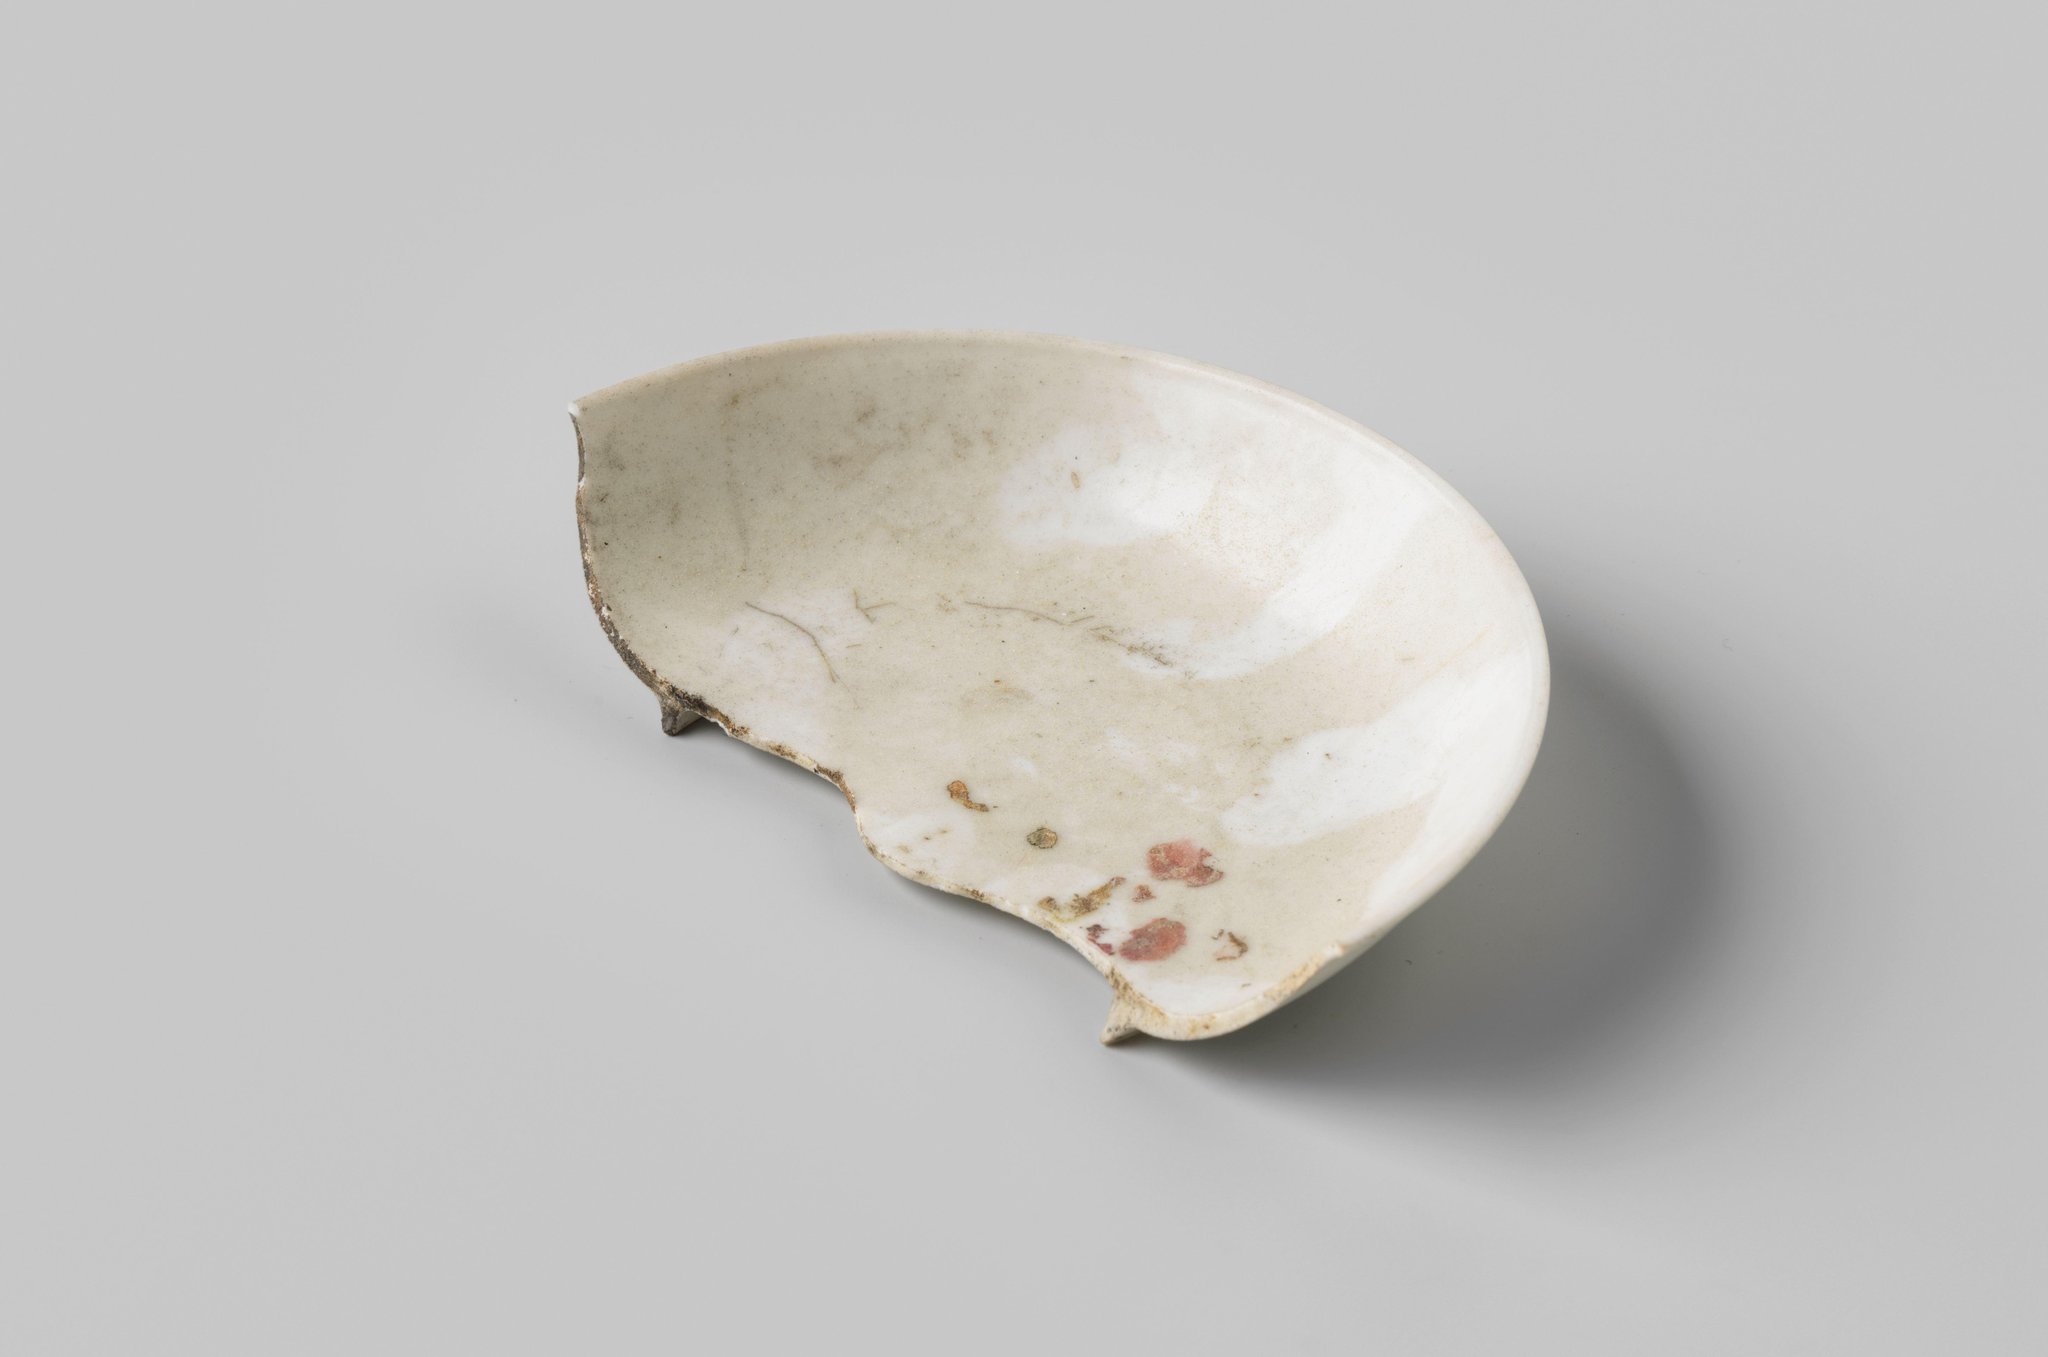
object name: platter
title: Schotel, gevonden bij V.O.C.-schip Witte Leeuw, mogelijk afkomstig van Zeelelie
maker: Anonymous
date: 1775-1800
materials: porcelain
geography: china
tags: verenigde oostindische compagnie, sint-helena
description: Schotel gevonden bij V.O.C.-schip de 'Witte Leeuw', 50% aanwezig. Dit object is 18e-eeuws en kan dus niet van de vracht van de Witte Leeuw zijn. Onduidelijk is of het object van de site komt of dat het later is vermengd, mogelijk met materiaal van de Zeelelie.